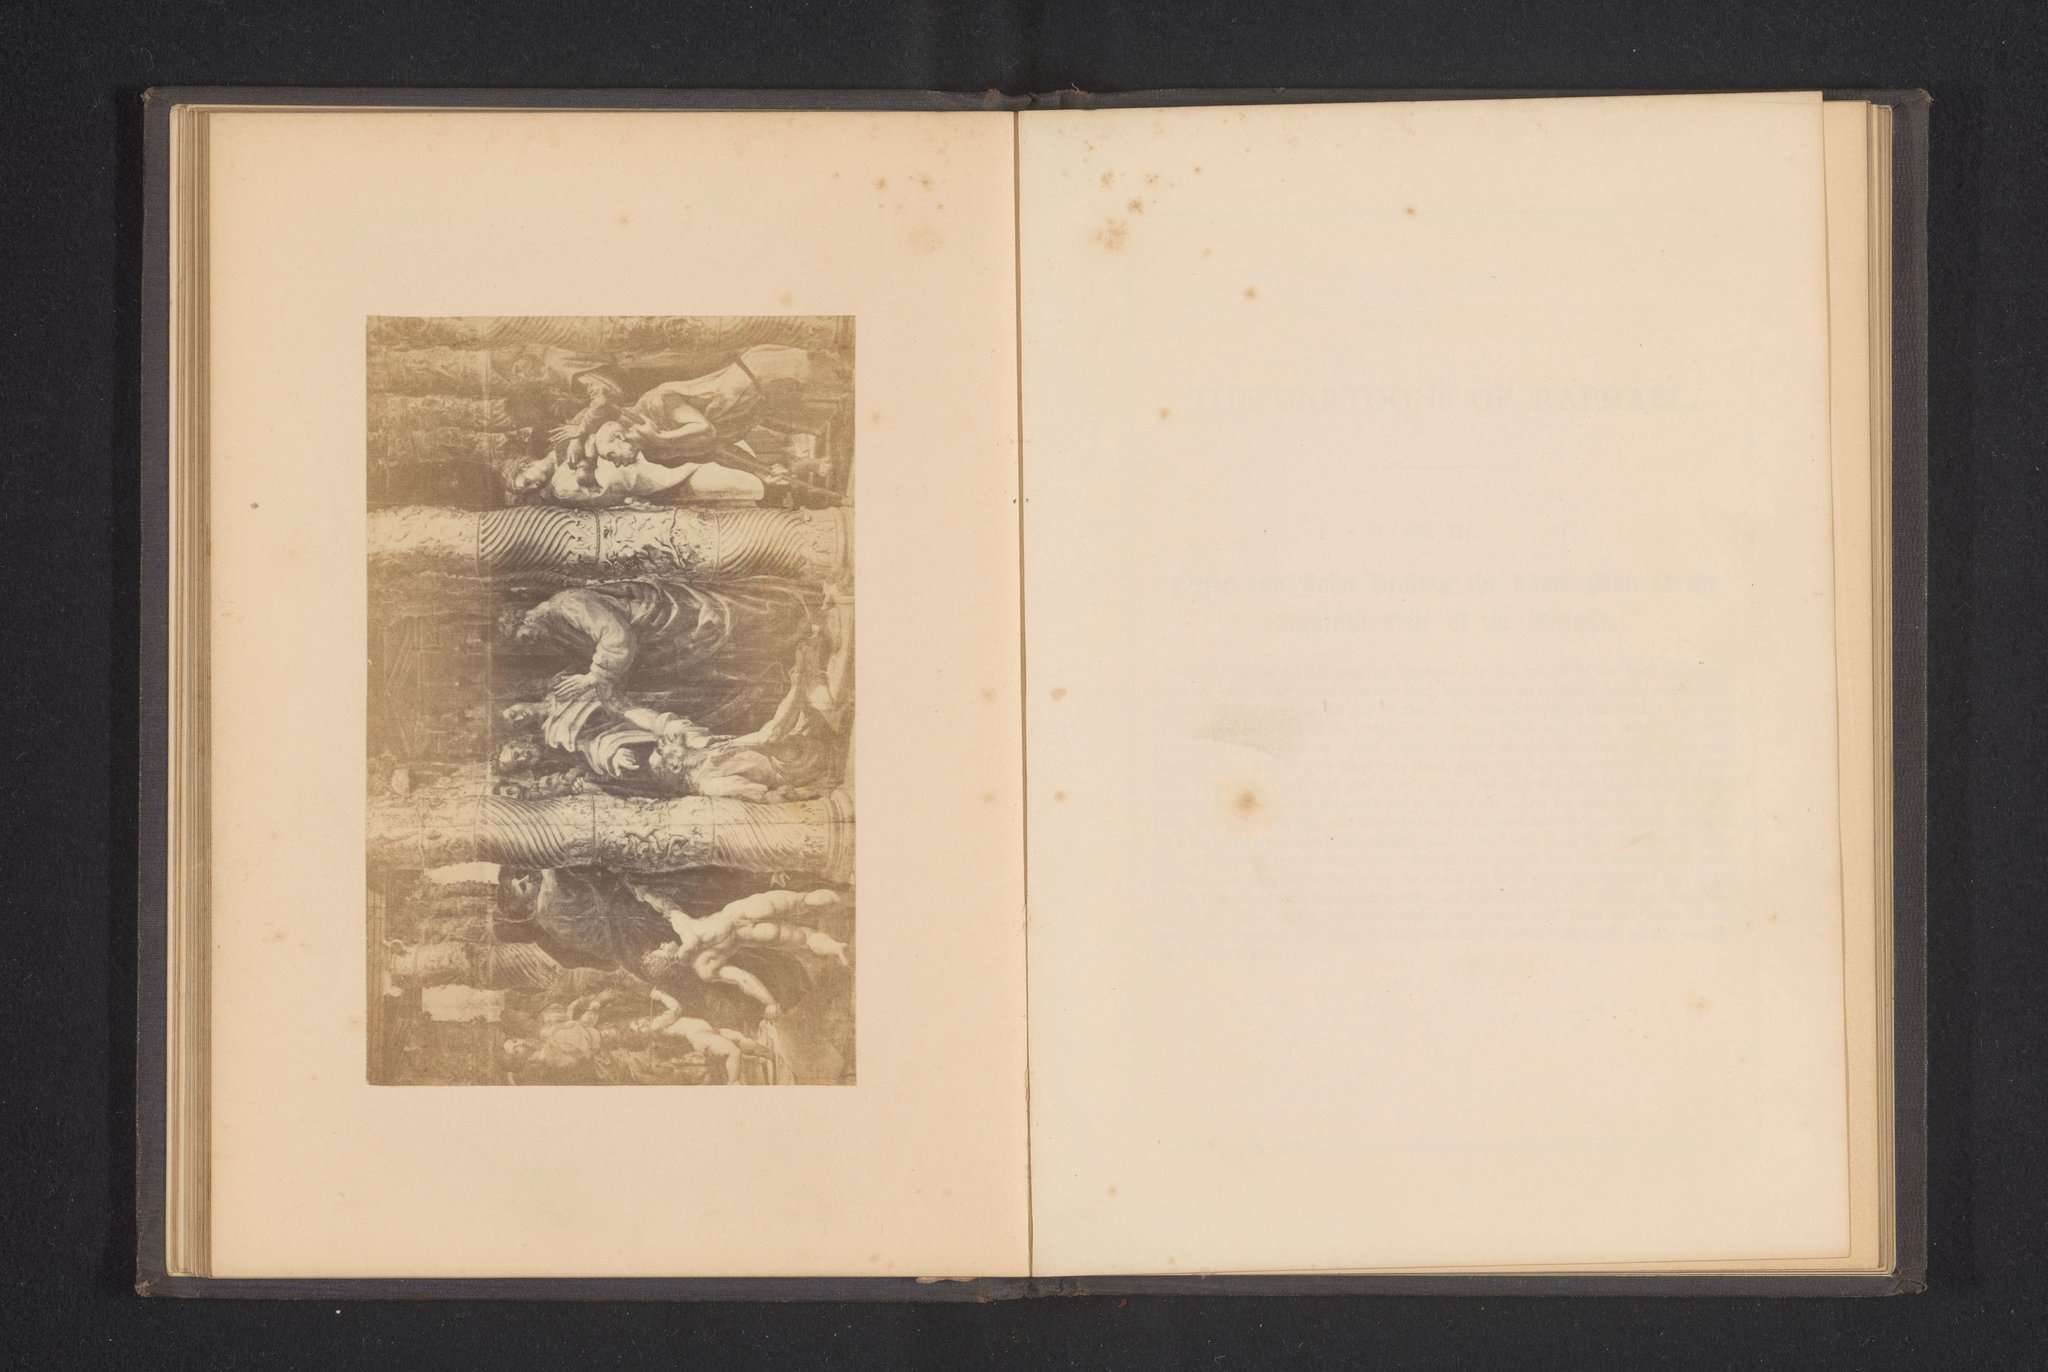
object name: photograph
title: Fotoreproductie van een kartonschildering, met een voorstelling van Petrus en Johannes die een verlamde man genezen voor de Tempel van Salomo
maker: Anonymous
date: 1850-1860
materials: photographic support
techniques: albumen print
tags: healing of a lame beggar at the beautiful gate of the temple by peter and john (acts 3 - 4:31)